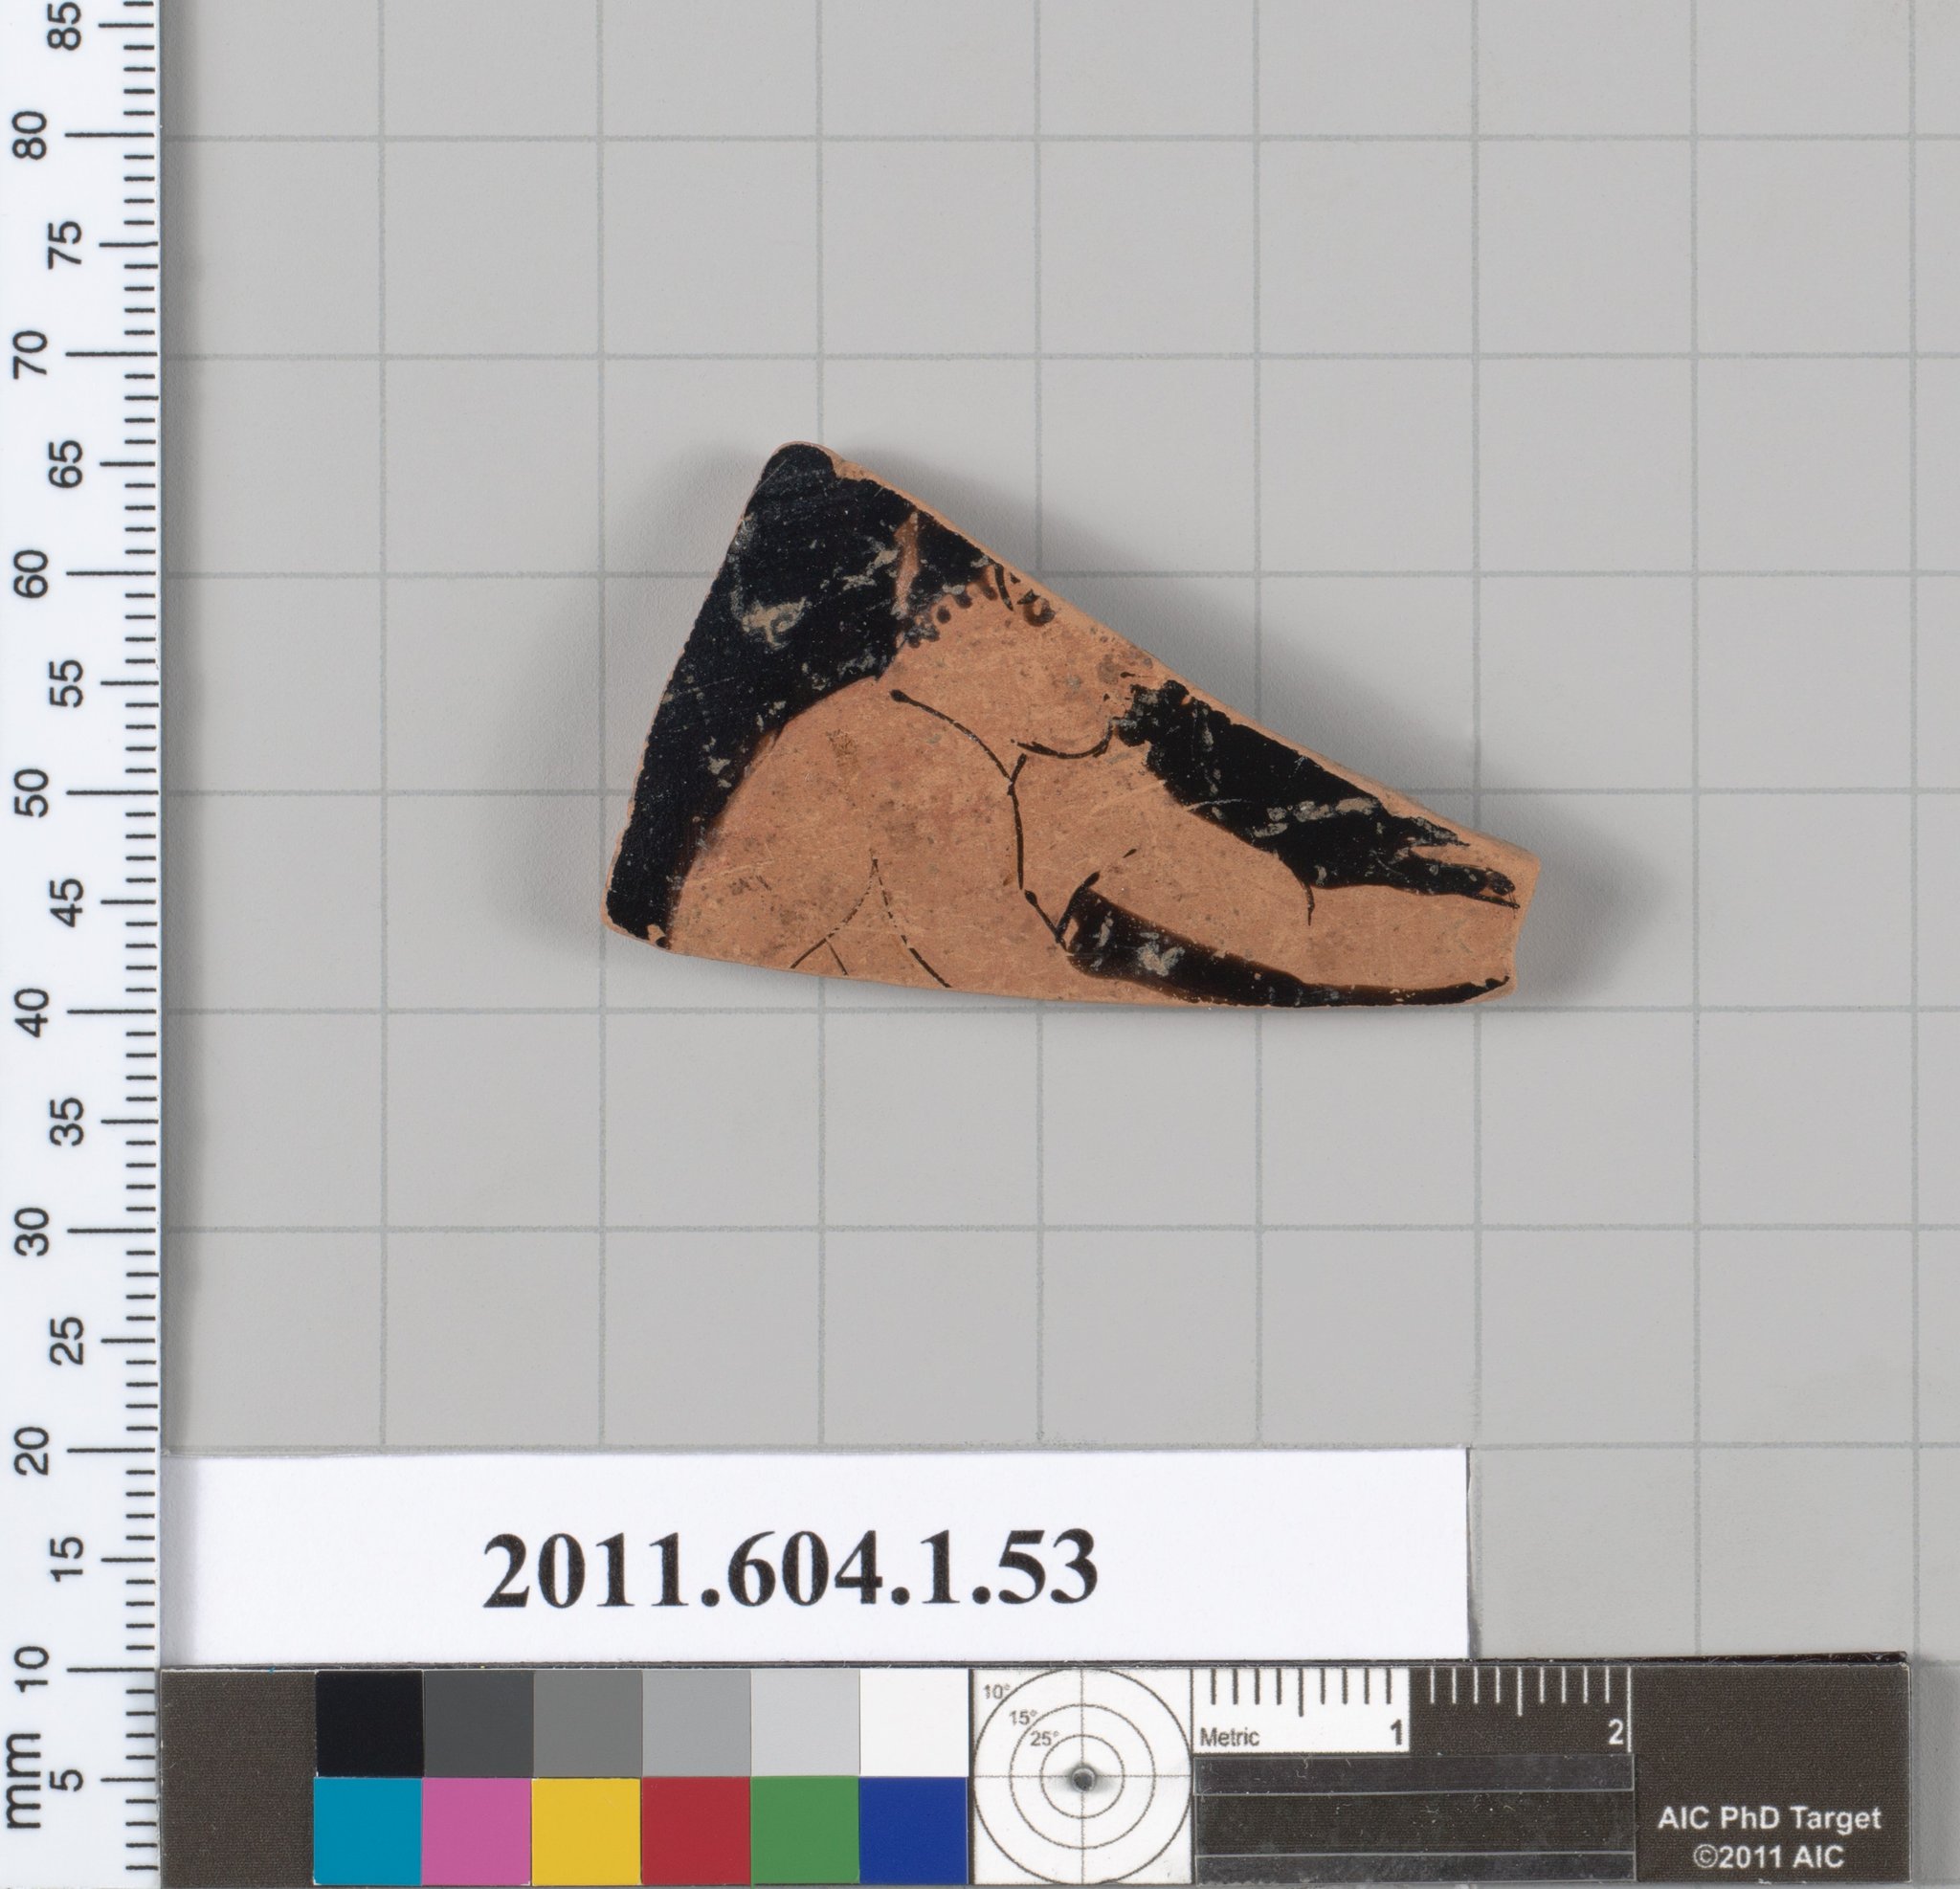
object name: kylix fragment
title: Terracotta fragment of a kylix (drinking cup)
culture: greek, attic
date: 460-450 BCE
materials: terracotta